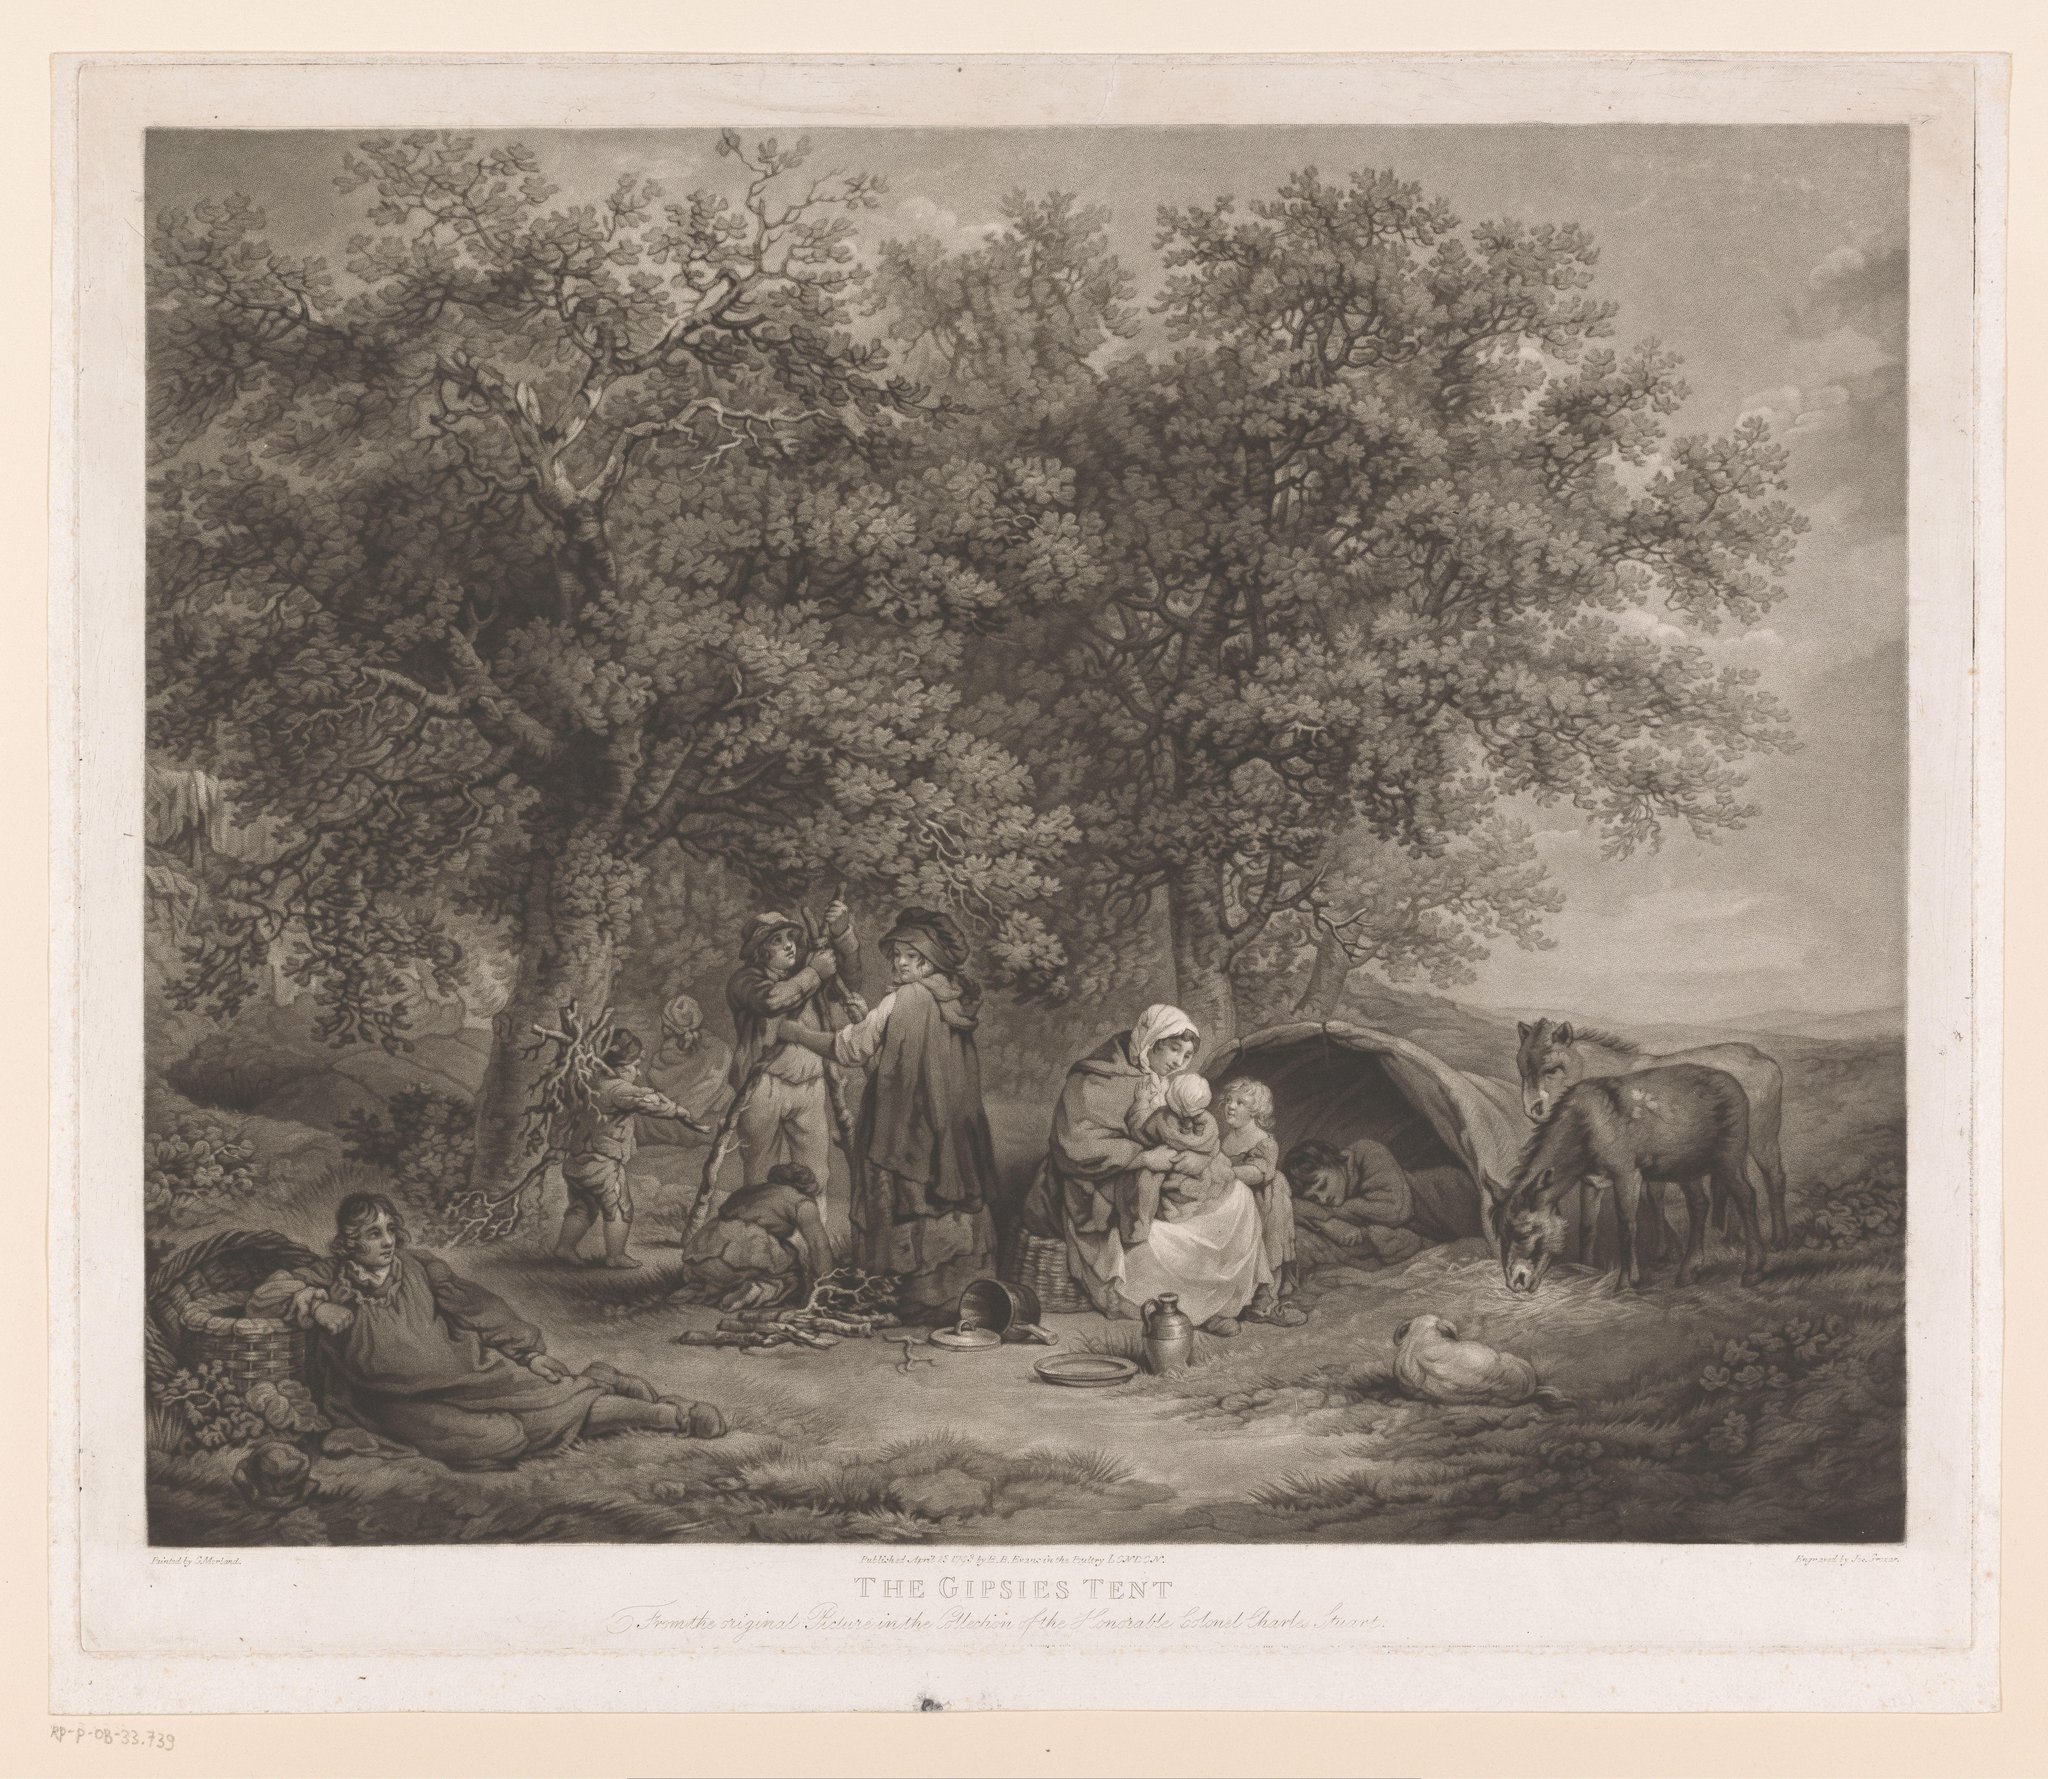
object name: print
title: The Gipsies Tent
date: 1793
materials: paper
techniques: roulette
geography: london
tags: wandering communities: romani or roma, camp-fire; watch-fire, fringe, edge of the wood (+ landscape with figures, staffage)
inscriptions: collector's mark: Lugt 2228